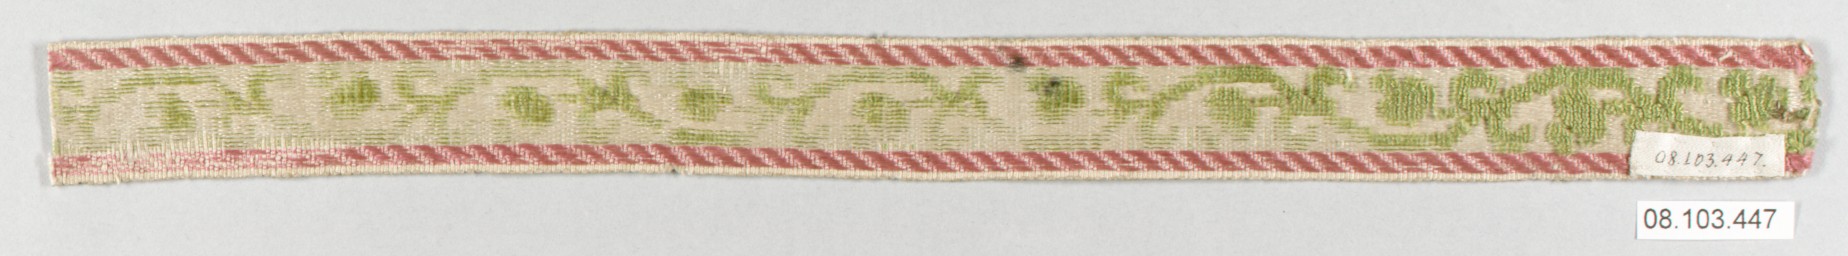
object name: galloon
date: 1801-1900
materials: silk